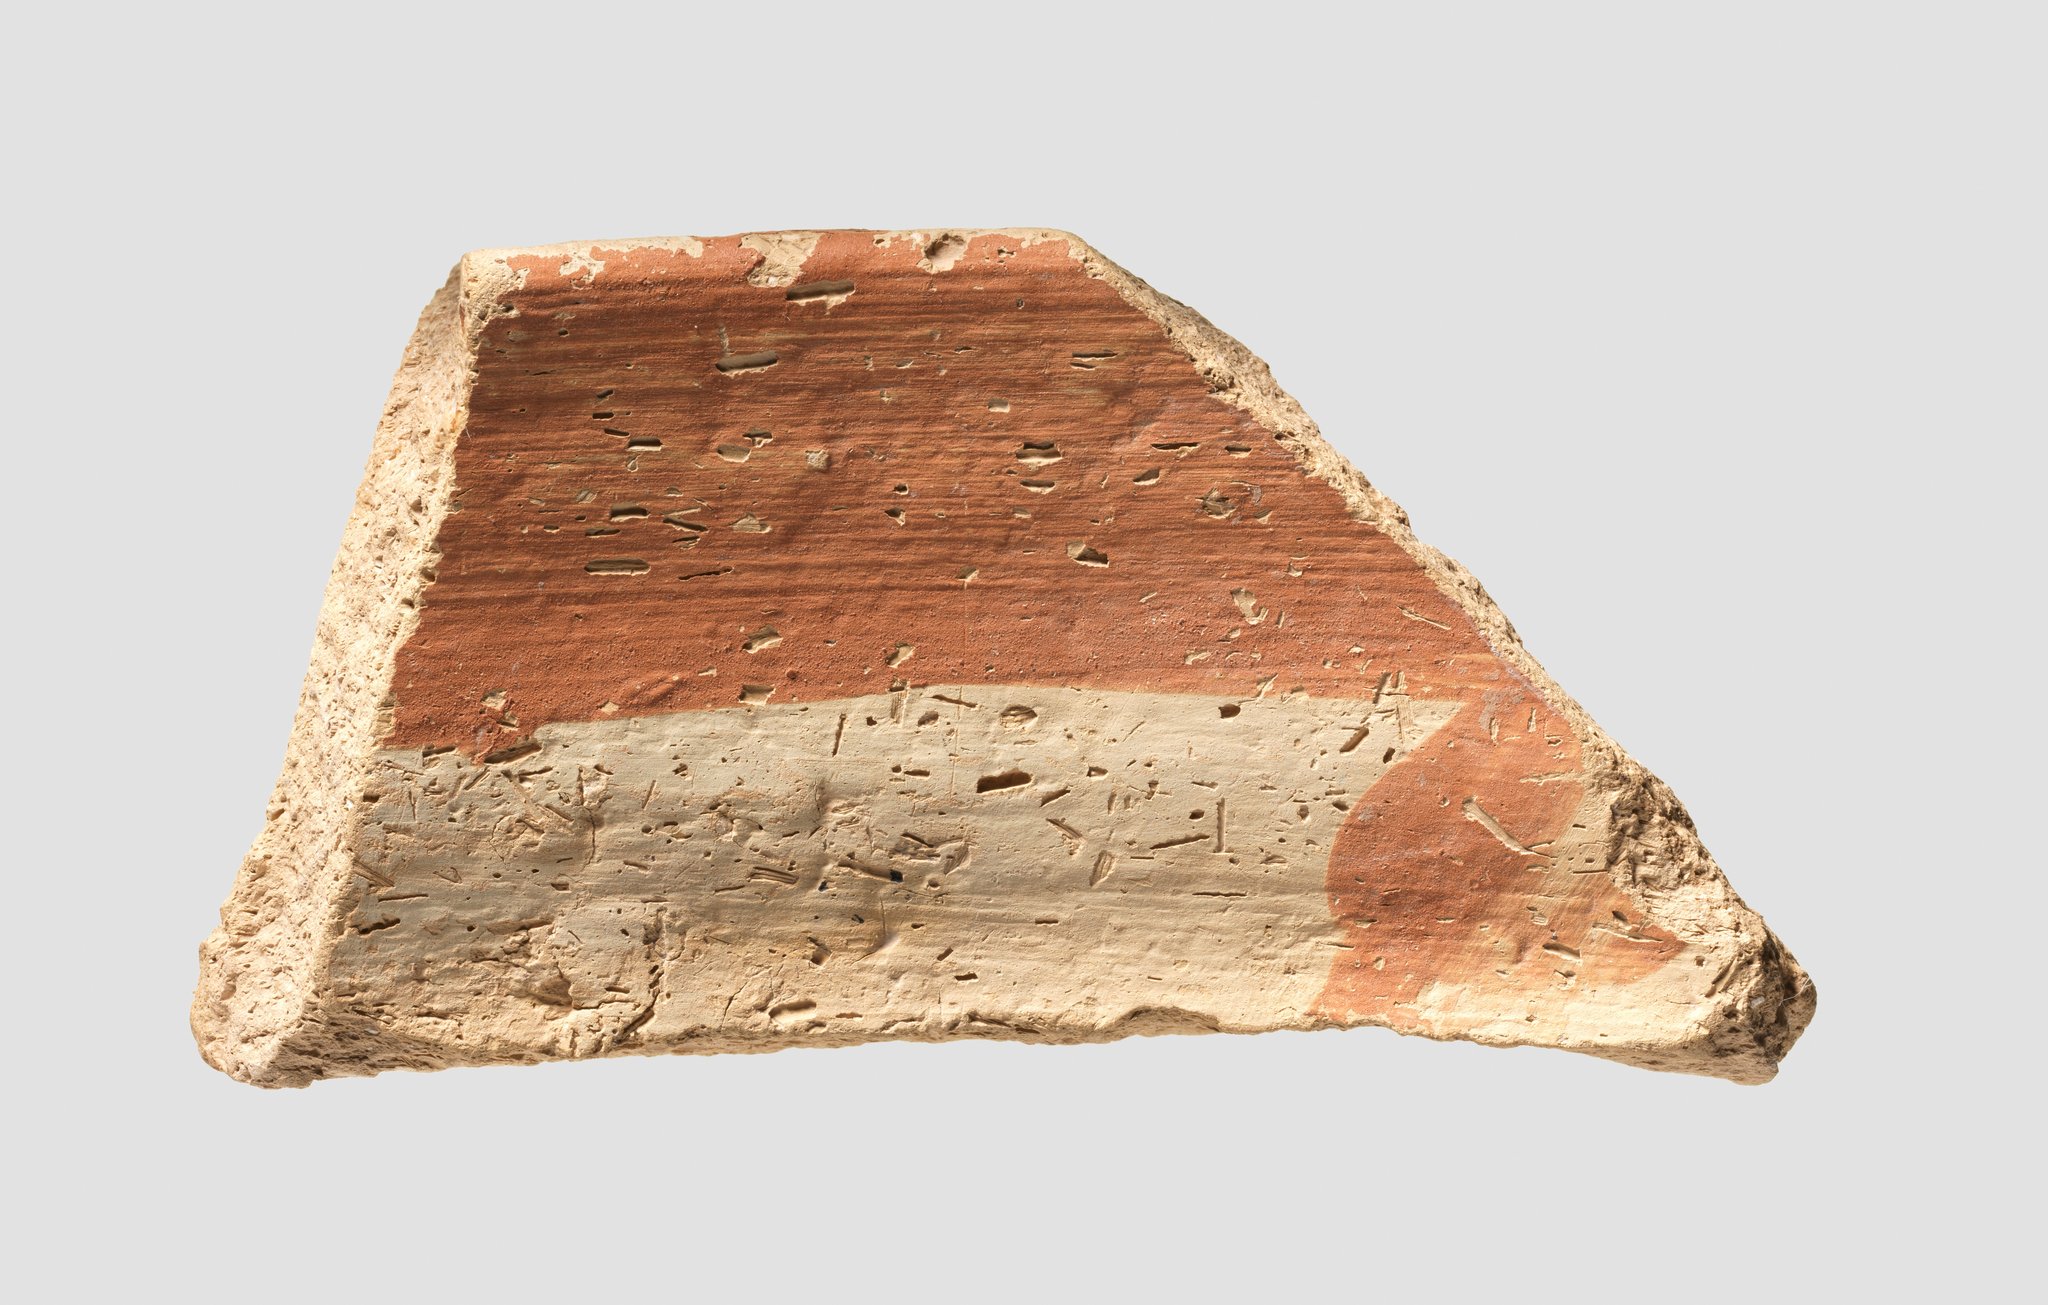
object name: sherd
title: Rim sherd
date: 2000-1668 BCE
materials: ceramic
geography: mesopotamia